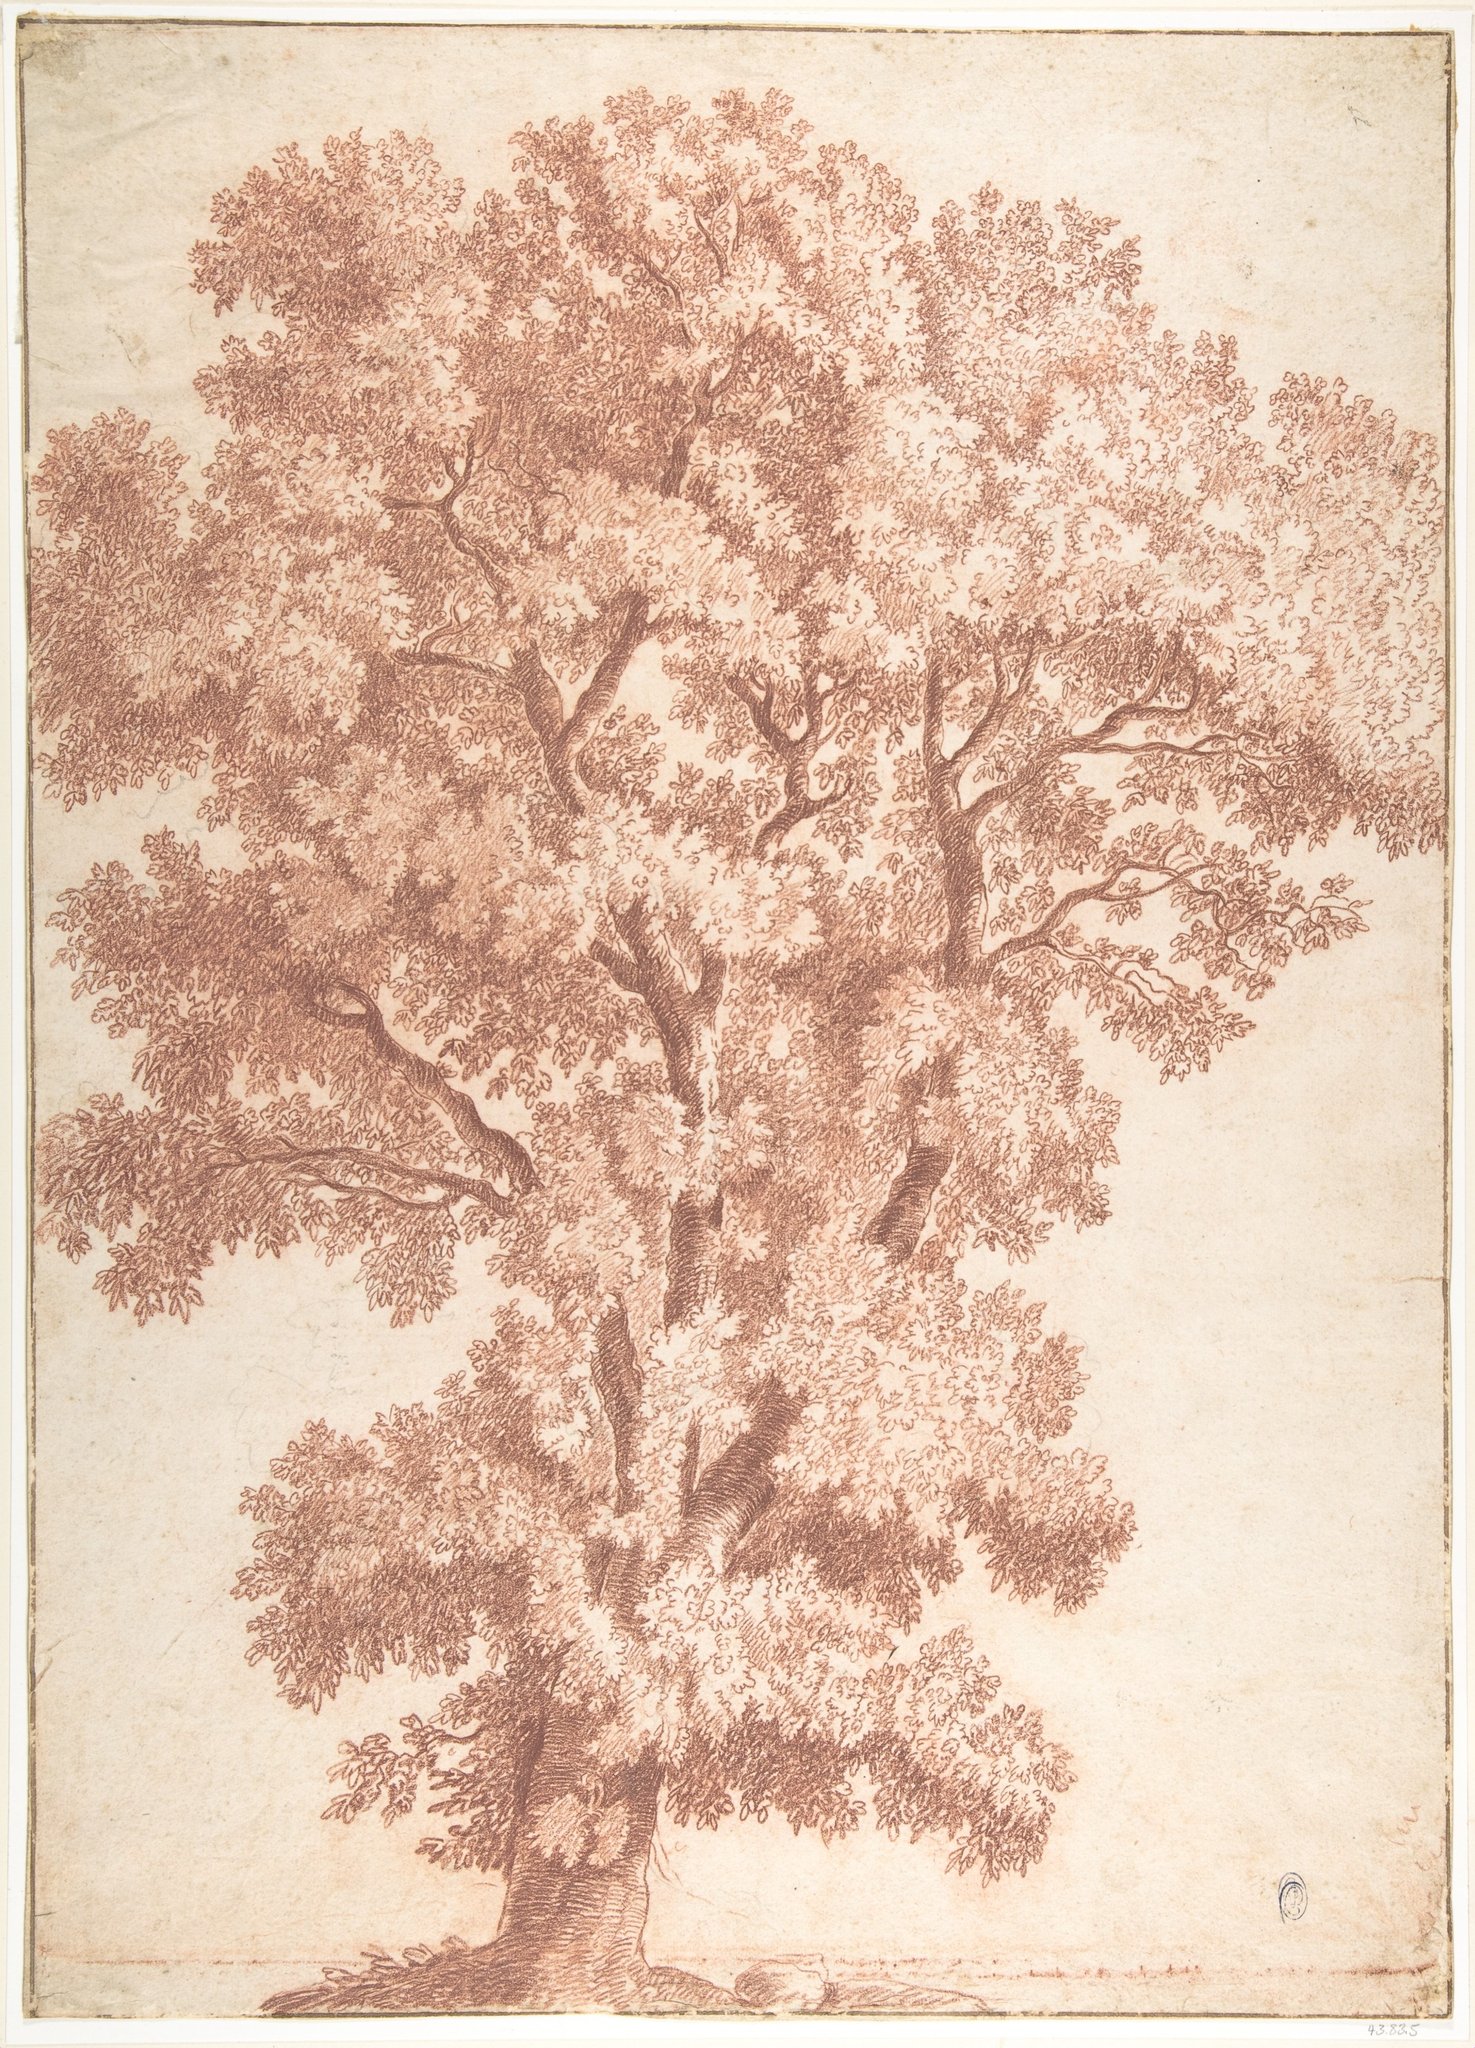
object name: drawing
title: Tree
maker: anonymous, italian, roman-bolognese, 17th century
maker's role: artist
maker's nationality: italian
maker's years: 1600-1700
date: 1601-1700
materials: chalk, ink, paper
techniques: pen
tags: trees